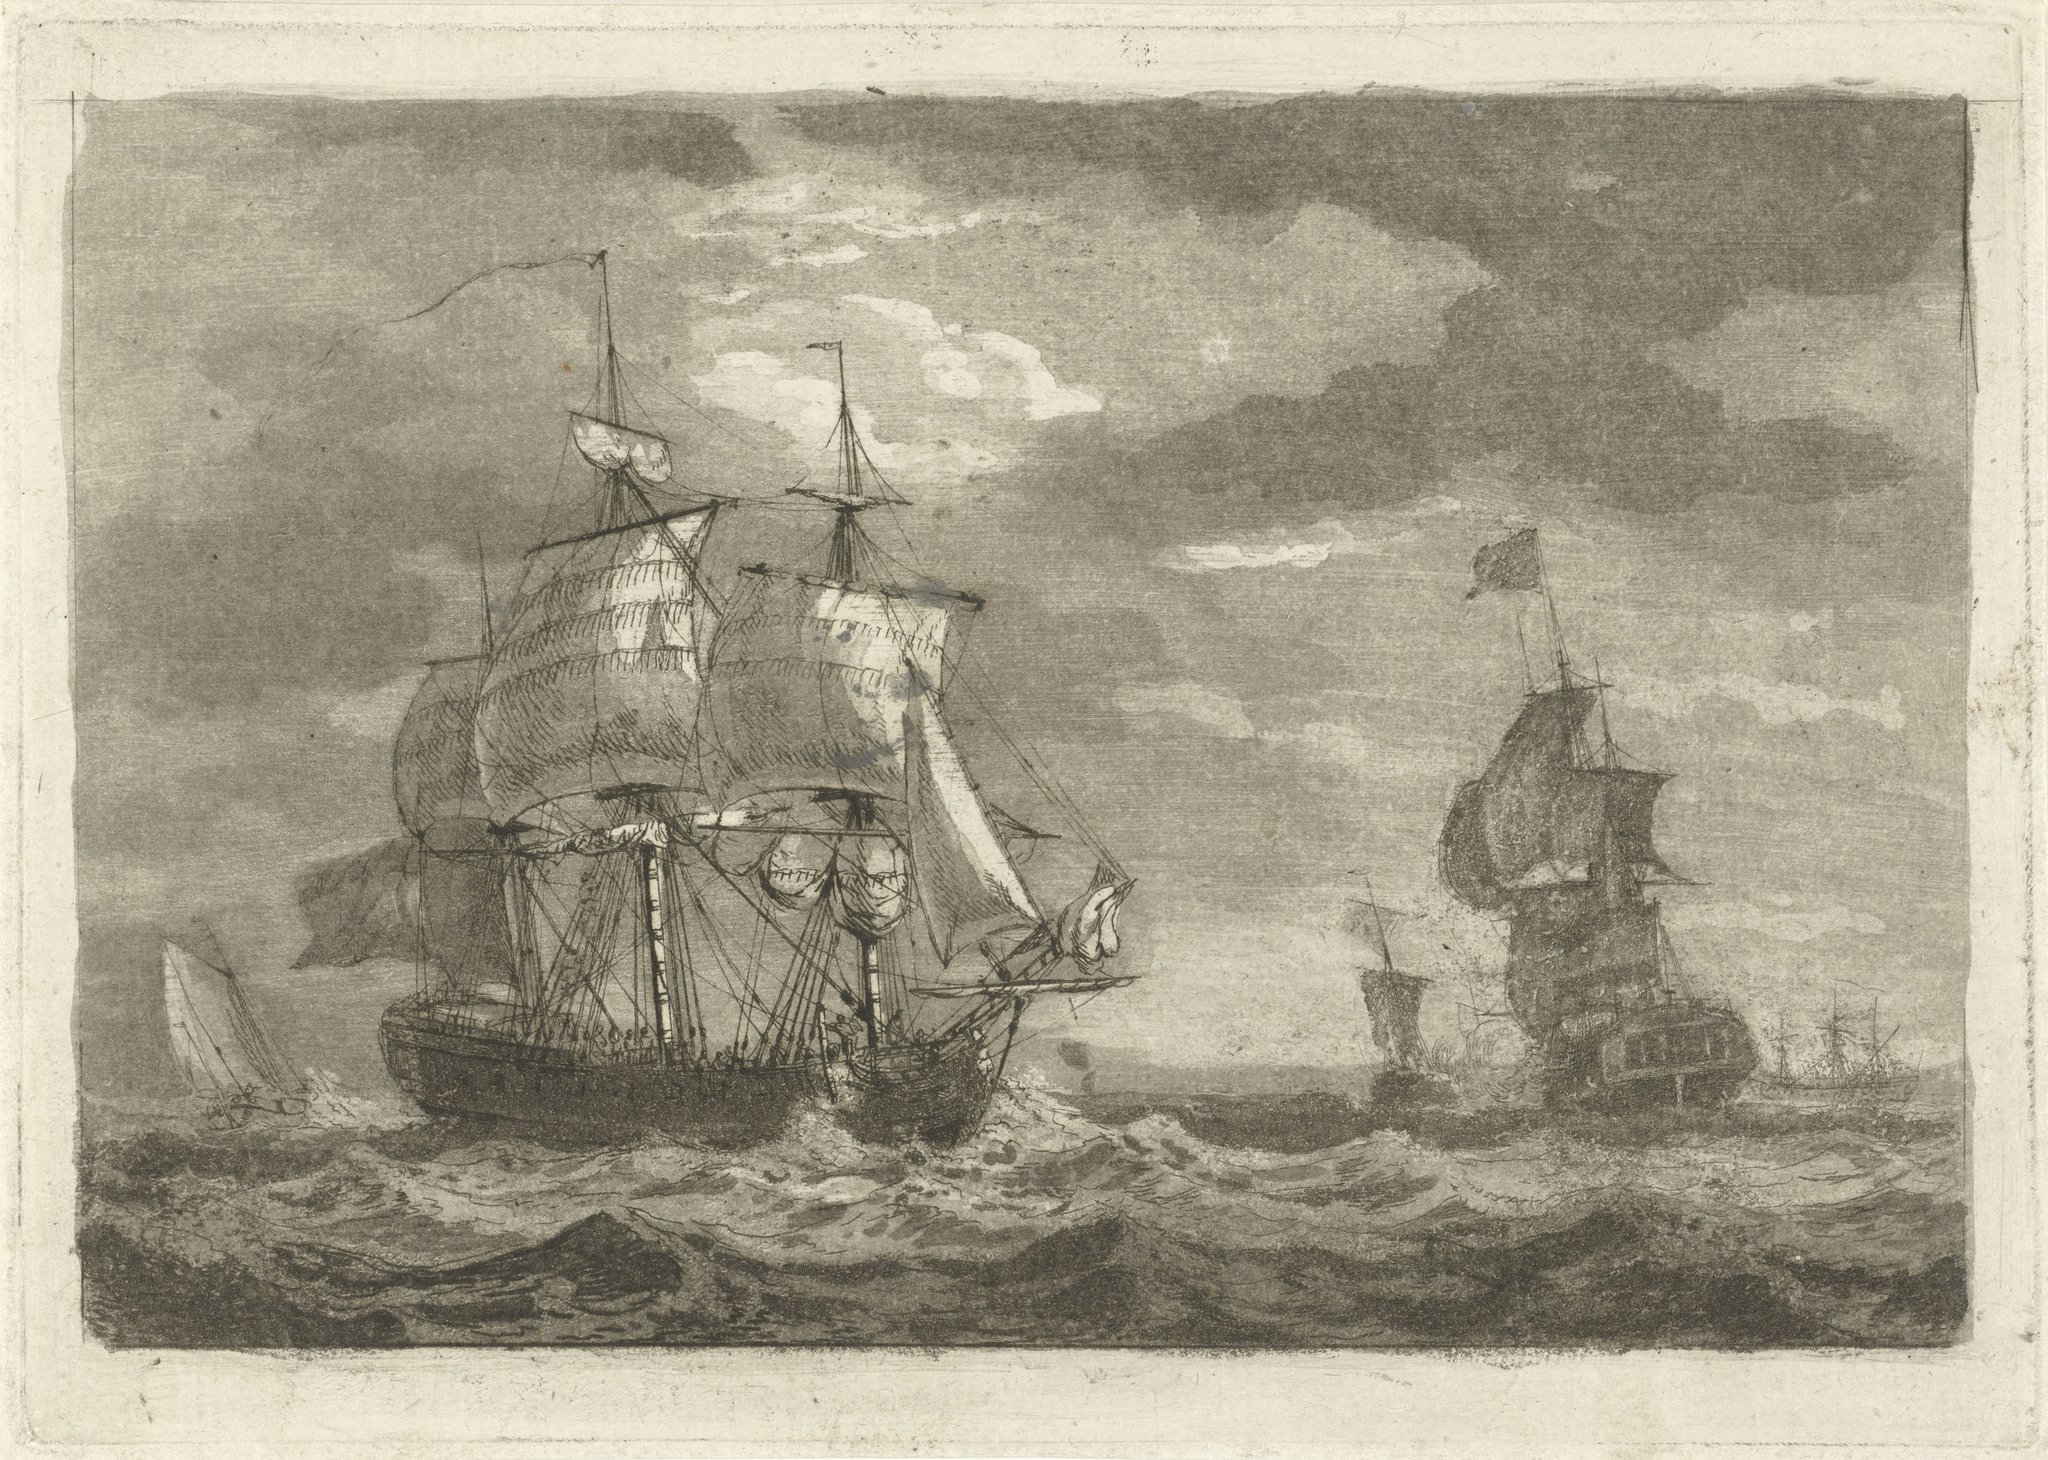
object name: print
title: Verschillende schepen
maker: gerrit groenewegen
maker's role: draughtsman, print maker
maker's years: 1754-1826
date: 1791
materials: paper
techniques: aquatint, etching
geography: rotterdam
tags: ships (in general) - cc - more than one ship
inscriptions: collector's mark: Lugt 2228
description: Drie driemasters en enkele andere zeilschepen op onrustig water. Deze prent maakt deel uit van een serie van zes prenten met verschillende schepen.